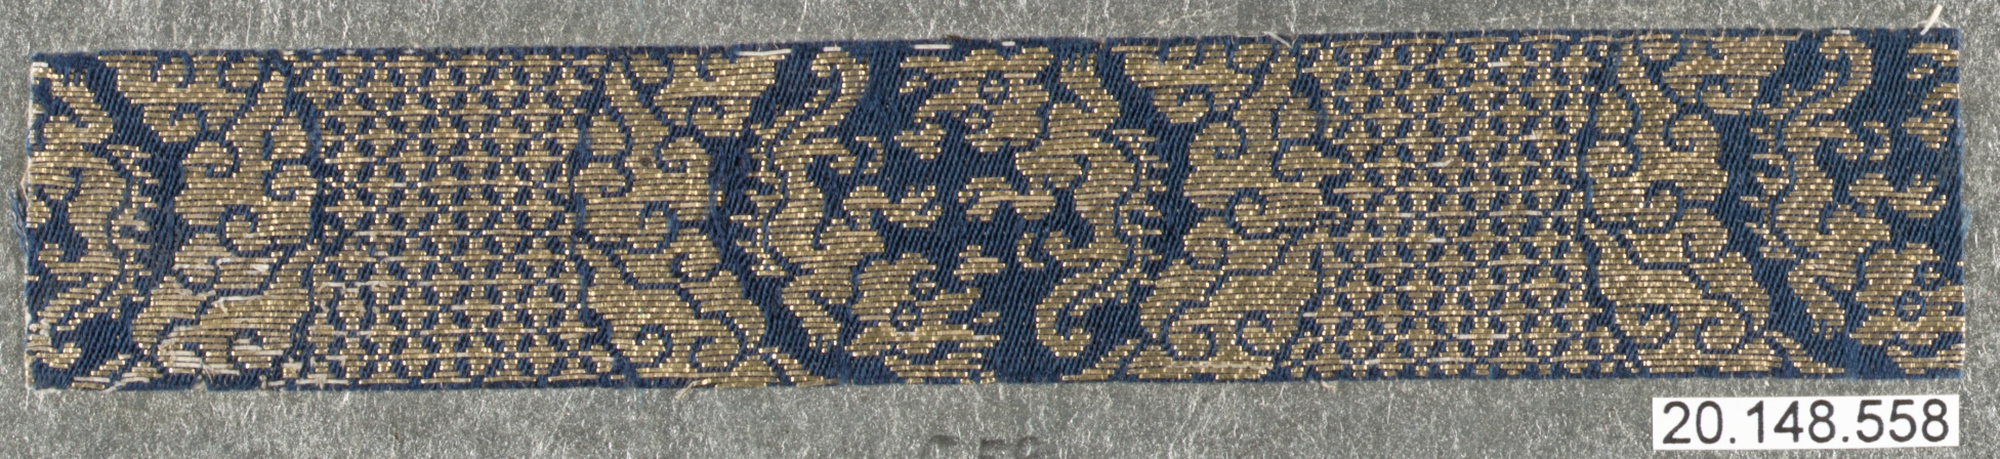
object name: piece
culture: japanese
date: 1701-1800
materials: silk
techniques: compound weave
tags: dragons